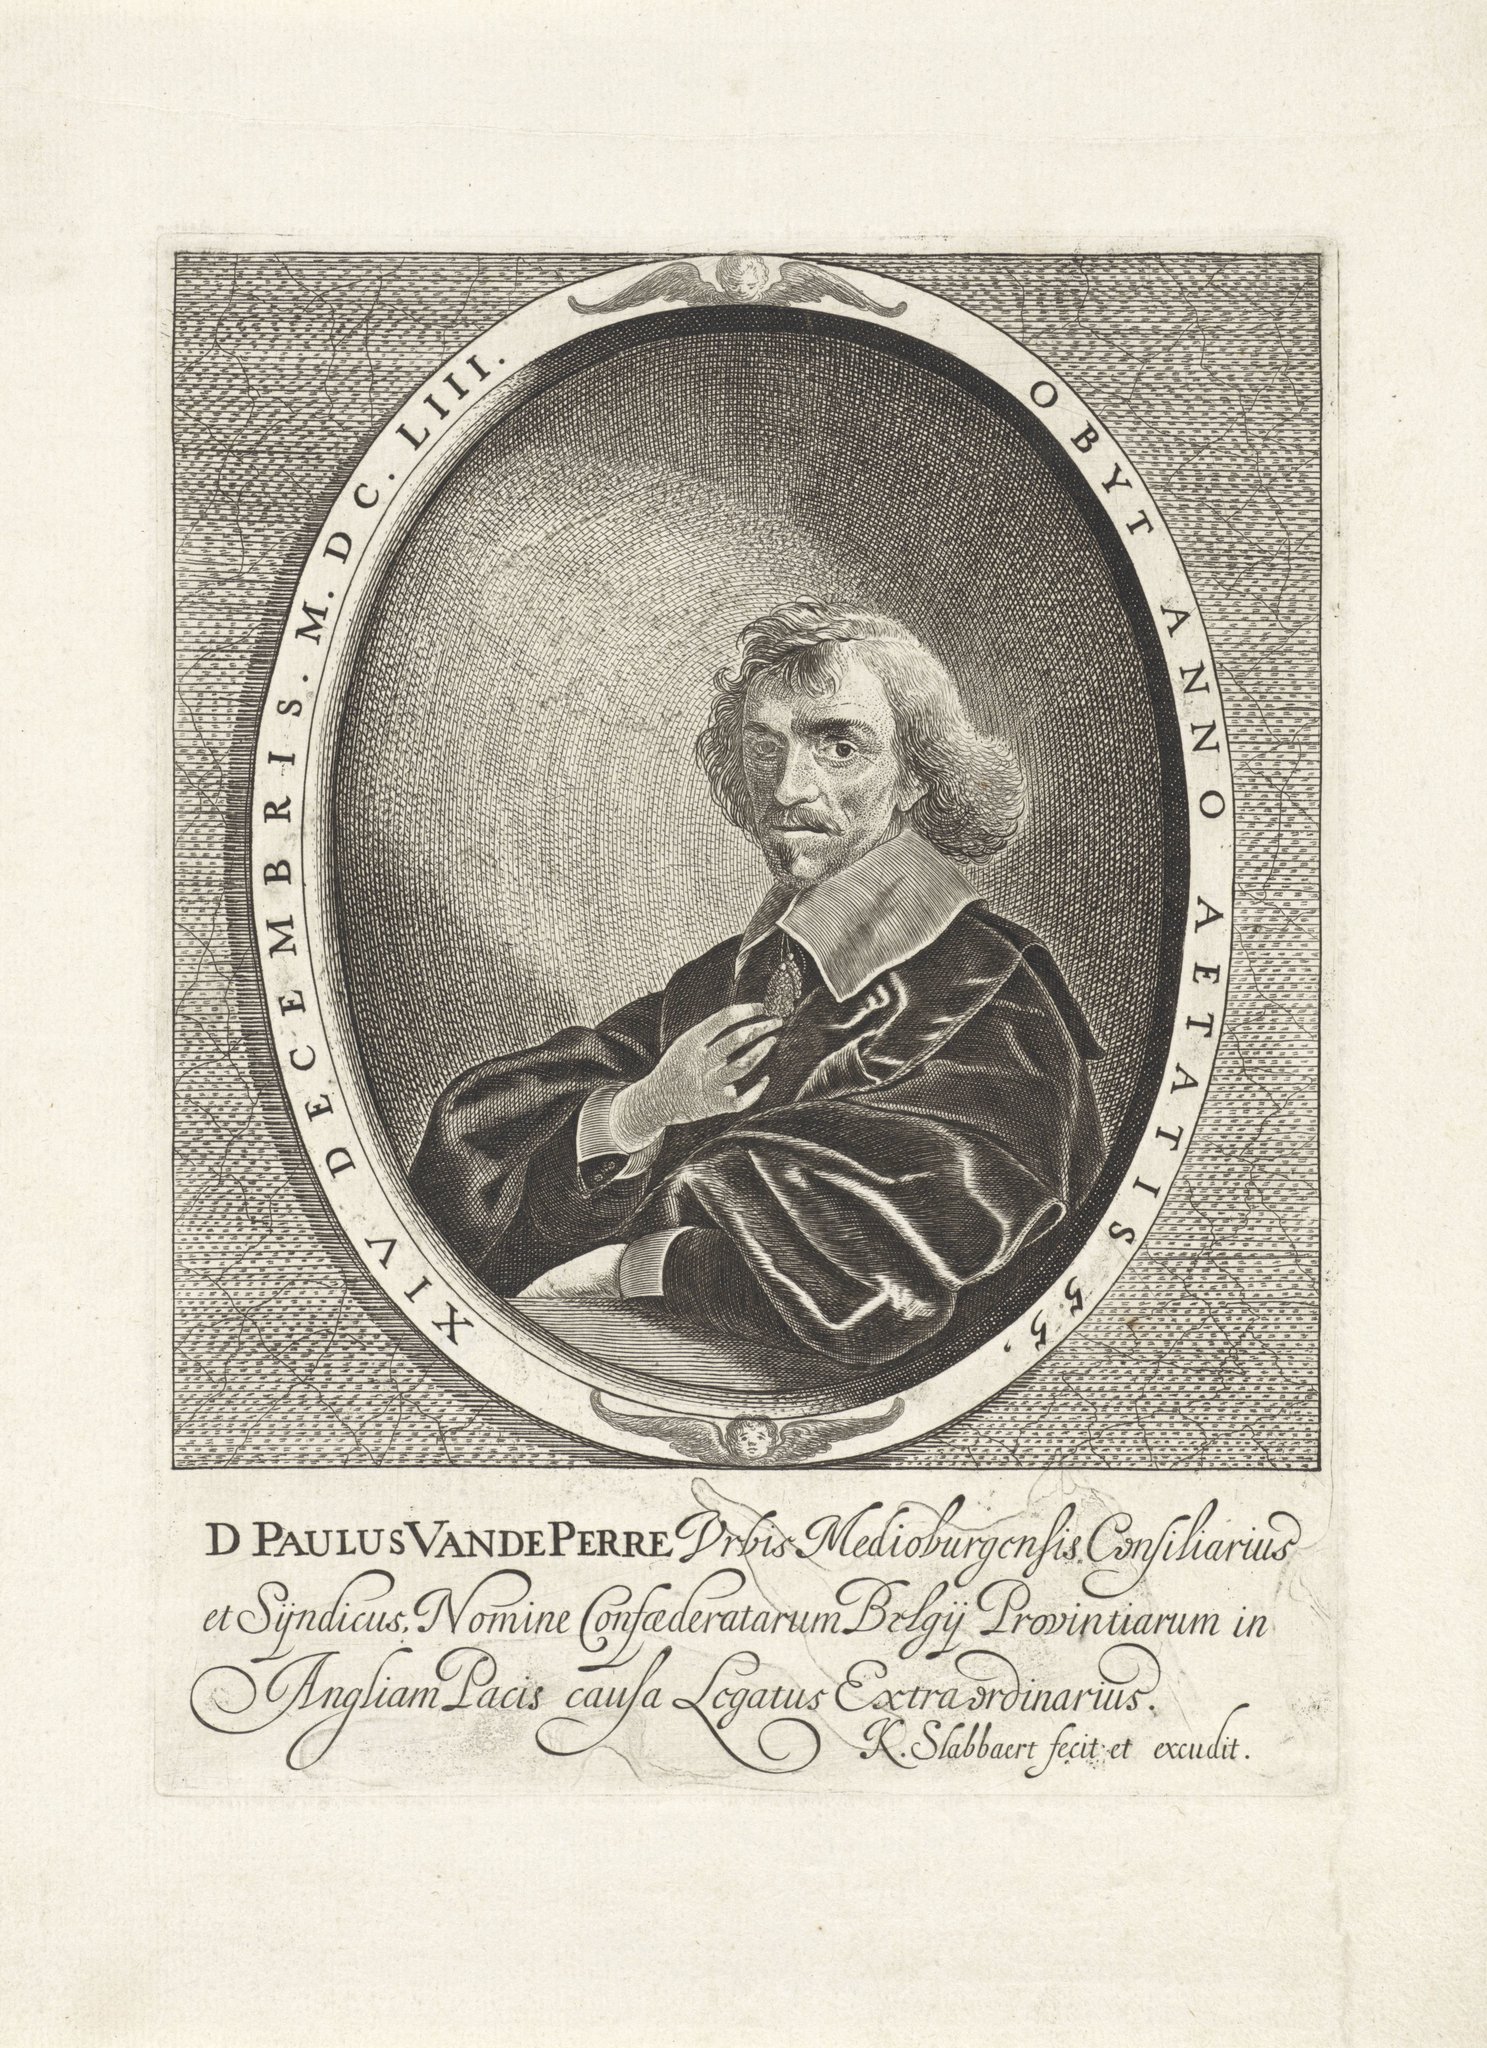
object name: print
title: Portret van Paulus van de Perre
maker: karel slabbaert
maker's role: draughtsman, painter, print maker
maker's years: 1618-1654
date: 1700-1750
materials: paper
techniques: engraving, etching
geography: middelburg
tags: london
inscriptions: collector's mark: Lugt 2228, collector's mark: Lugt 2760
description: Portret van de diplomaat Paulus van der Perre. Rondom zijn portret zijn sterfdatum. Onder de prent vier regels in het Latijn met zijn naam en enkele van de functies die hij bekleedde.